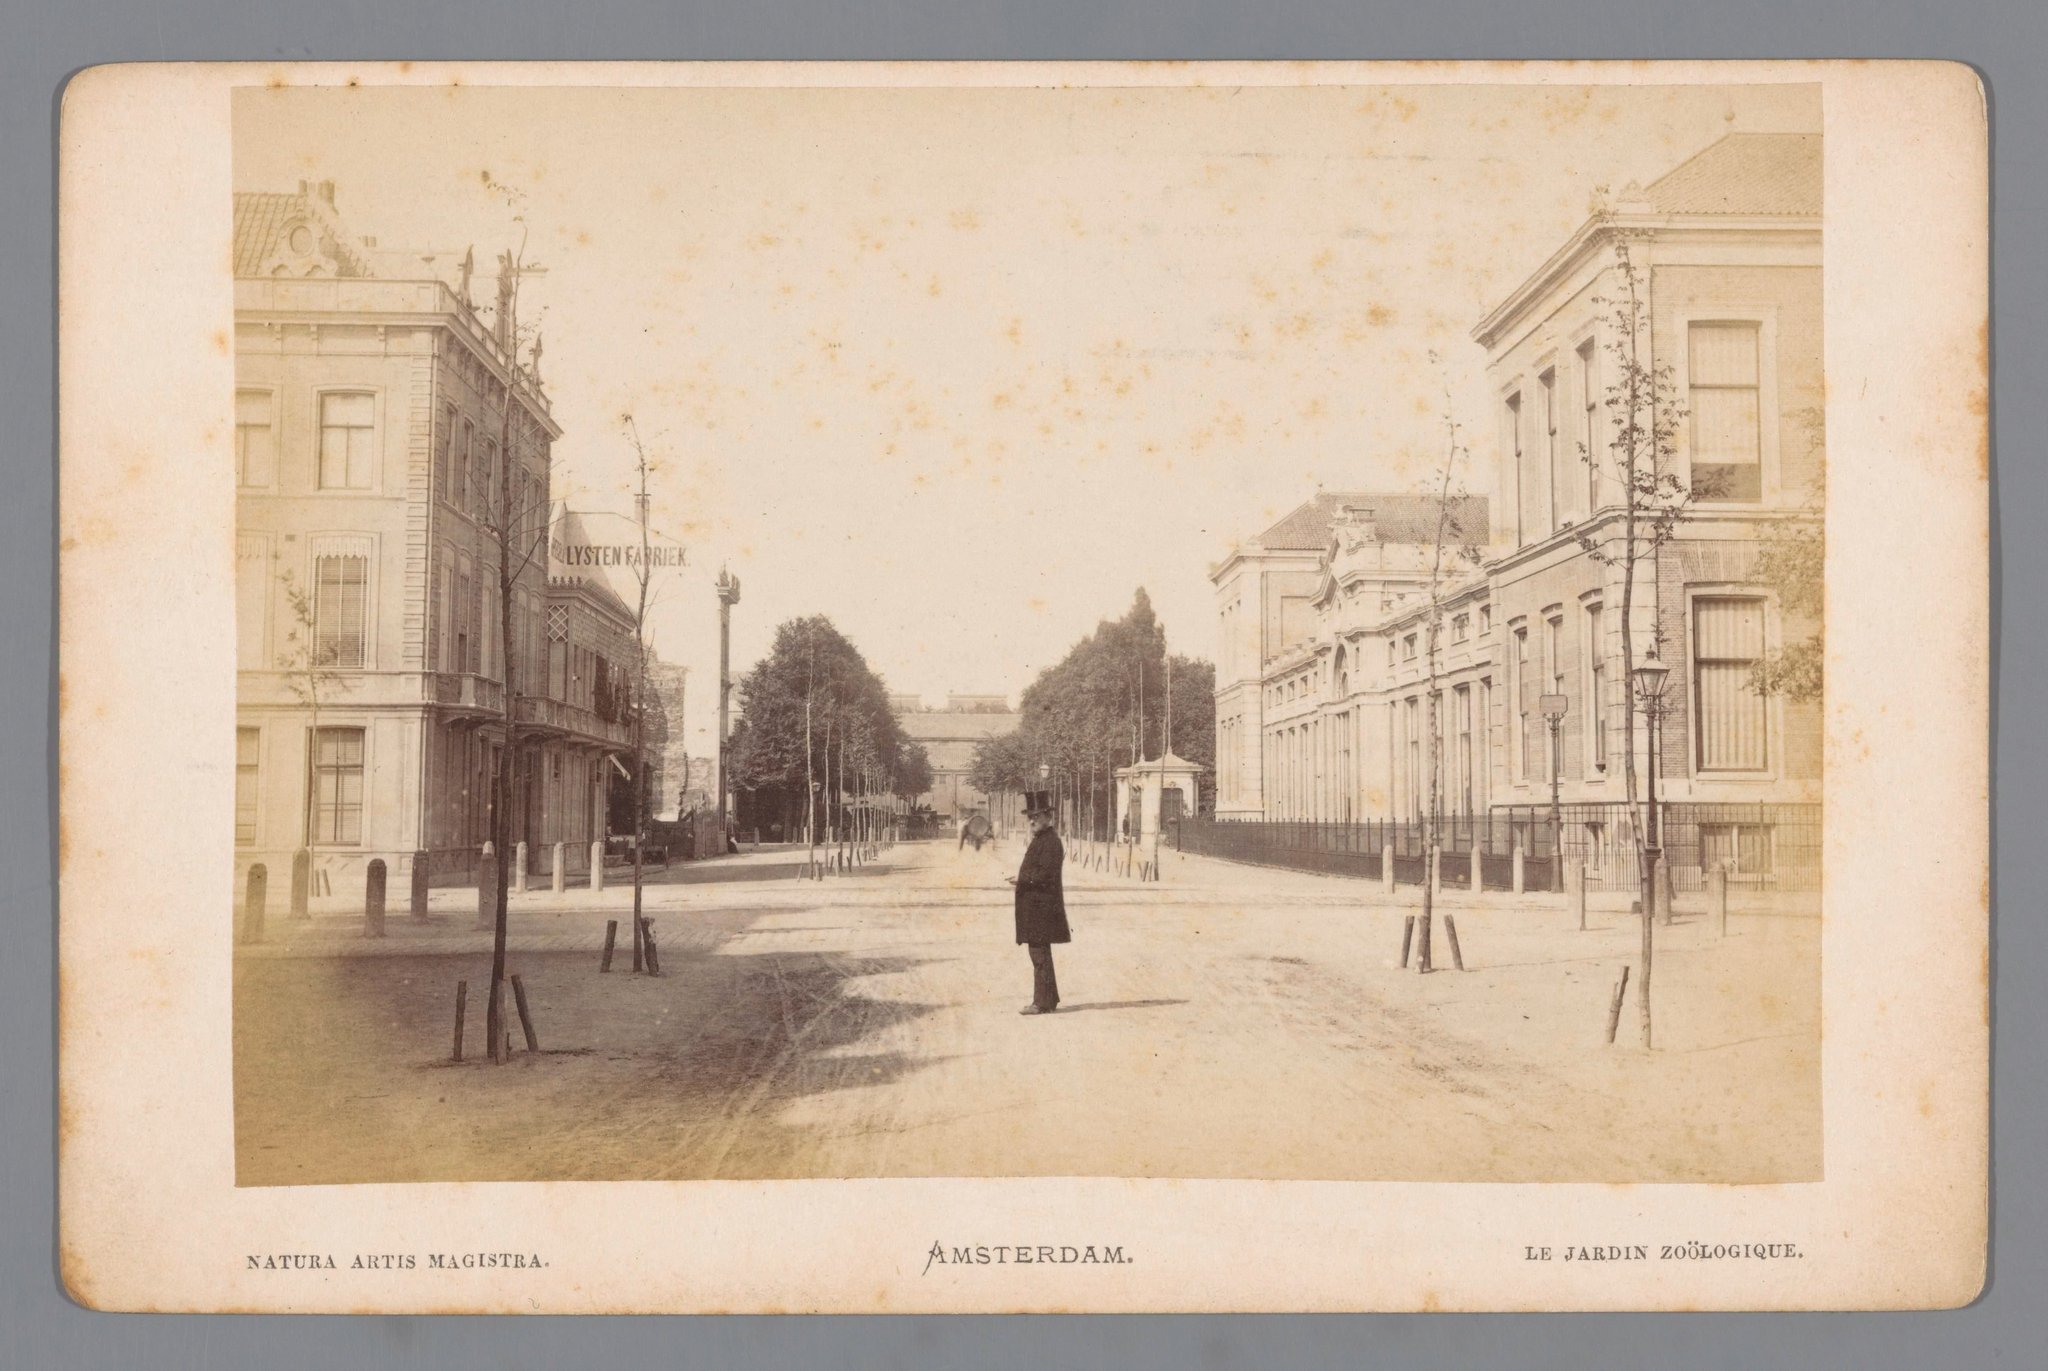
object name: cabinet photograph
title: Amsterdam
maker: andries jager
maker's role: publisher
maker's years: 1825-1905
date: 1860-1890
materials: cardboard, photographic support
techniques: albumen print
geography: amsterdam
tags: road, path, zoological garden, zoo, seen as place where non-domestic animals are kept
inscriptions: number: ‘19’